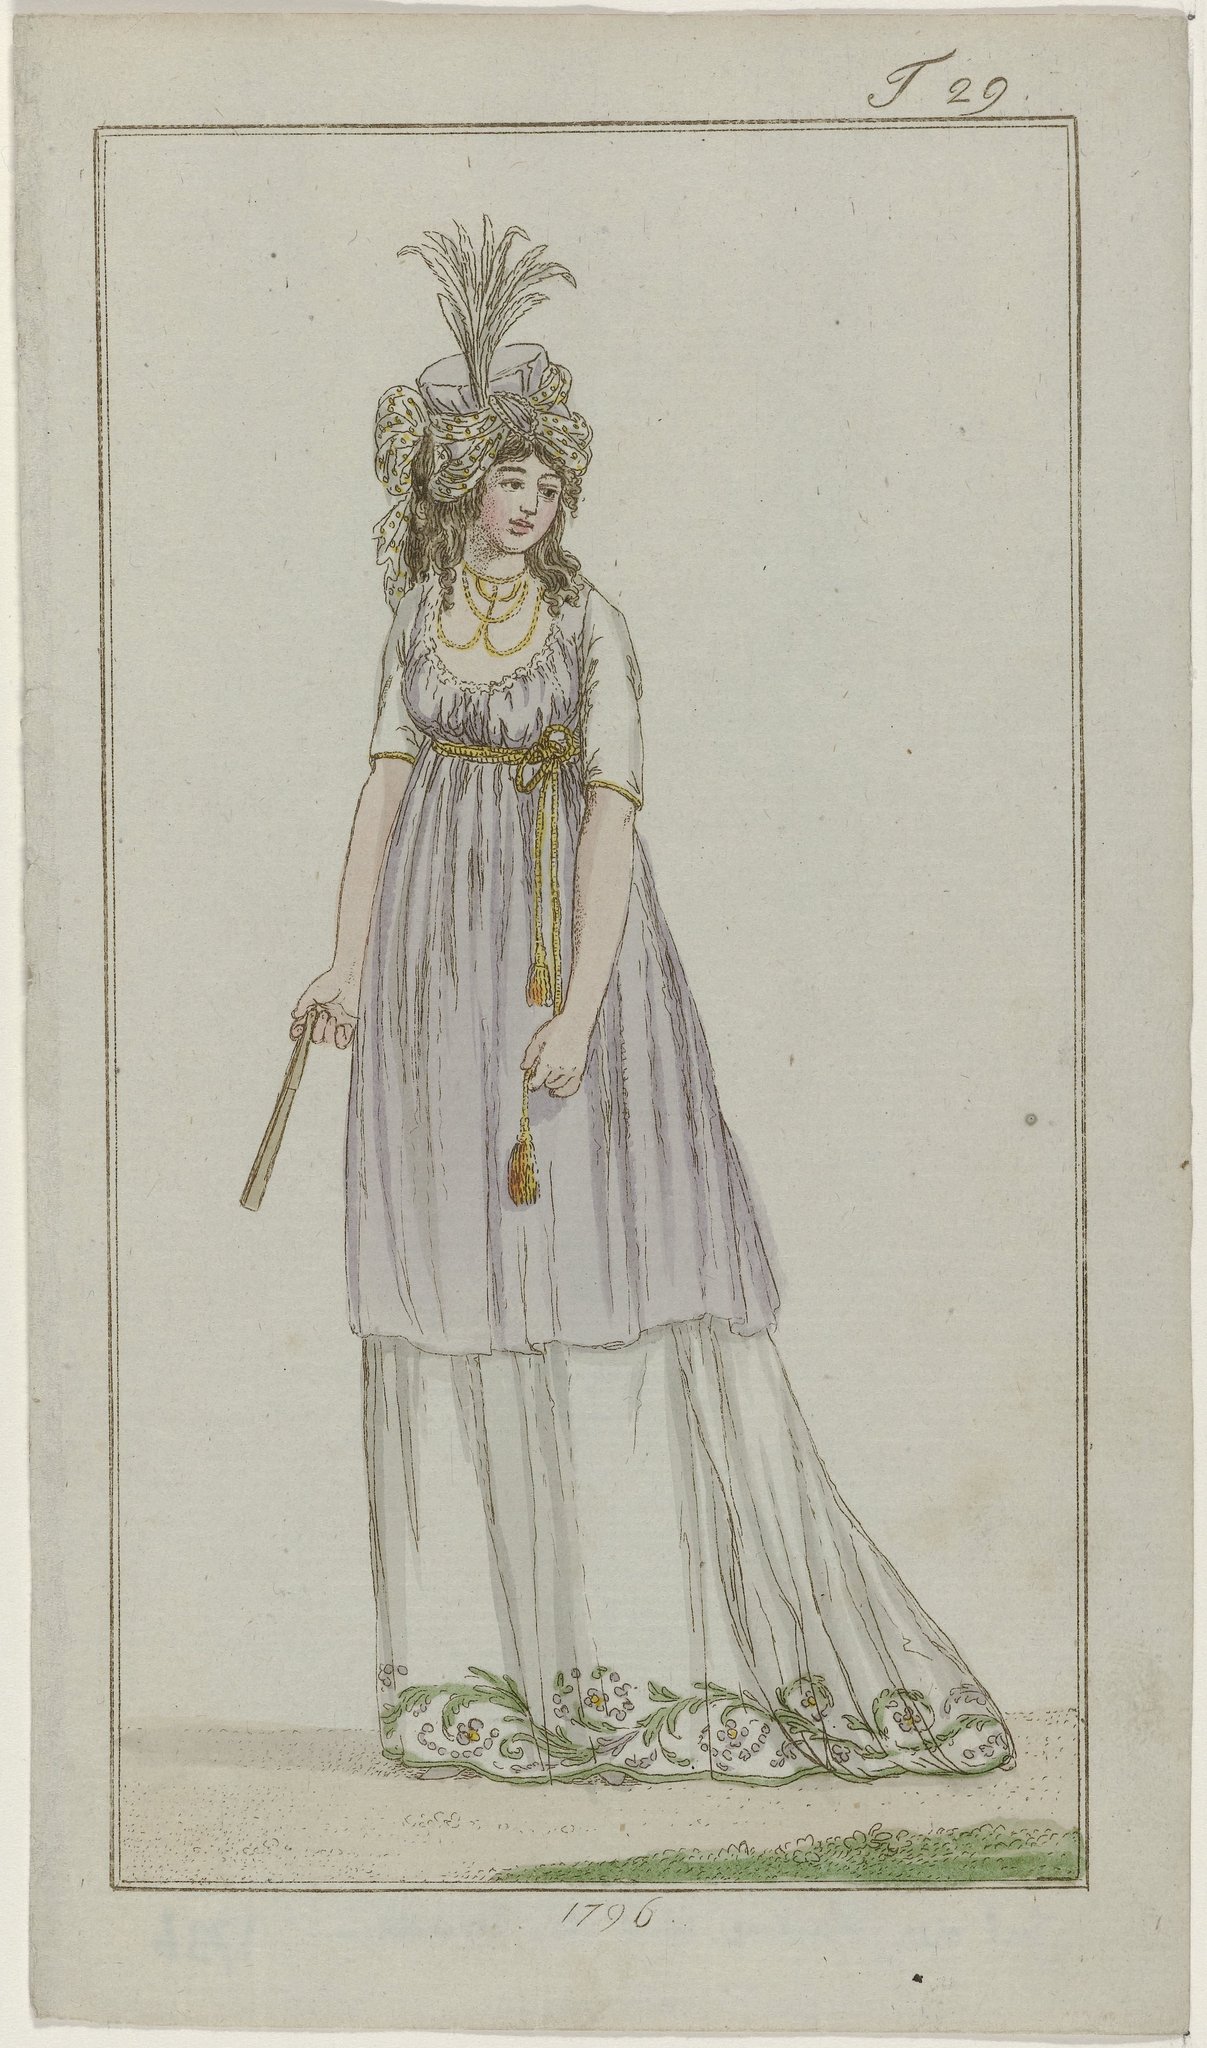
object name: fashion print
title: Journal des Luxus und der Moden, 1796, T 29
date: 1796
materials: paper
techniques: etching, hand coloring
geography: weimar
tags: clothing for the upper part of the body (+ women's clothes), ornamental parts of clothing (+ women's clothes), head-gear (+ women's clothes), fashion plates, dress, gown (+ women's clothes), fan (+ women's clothes), necklace (+ women's clothes)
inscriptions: date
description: Staande vrouw gekleed in een tuniek op een japon met sleep. De zoom versierd met een bloem- en bladmotief. Om de hoge taille een gestrikt koord met kwasten. Verdere accessoires: hoed versierd met gestippelde stof en pluim, collier, waaier. Prent uit het modetijdschrift Journal des Luxus und der Moden, uitgegeven door Friedrich Justin Bertuch en Georg Melchior Kraus, Weimar, 1786-1826.